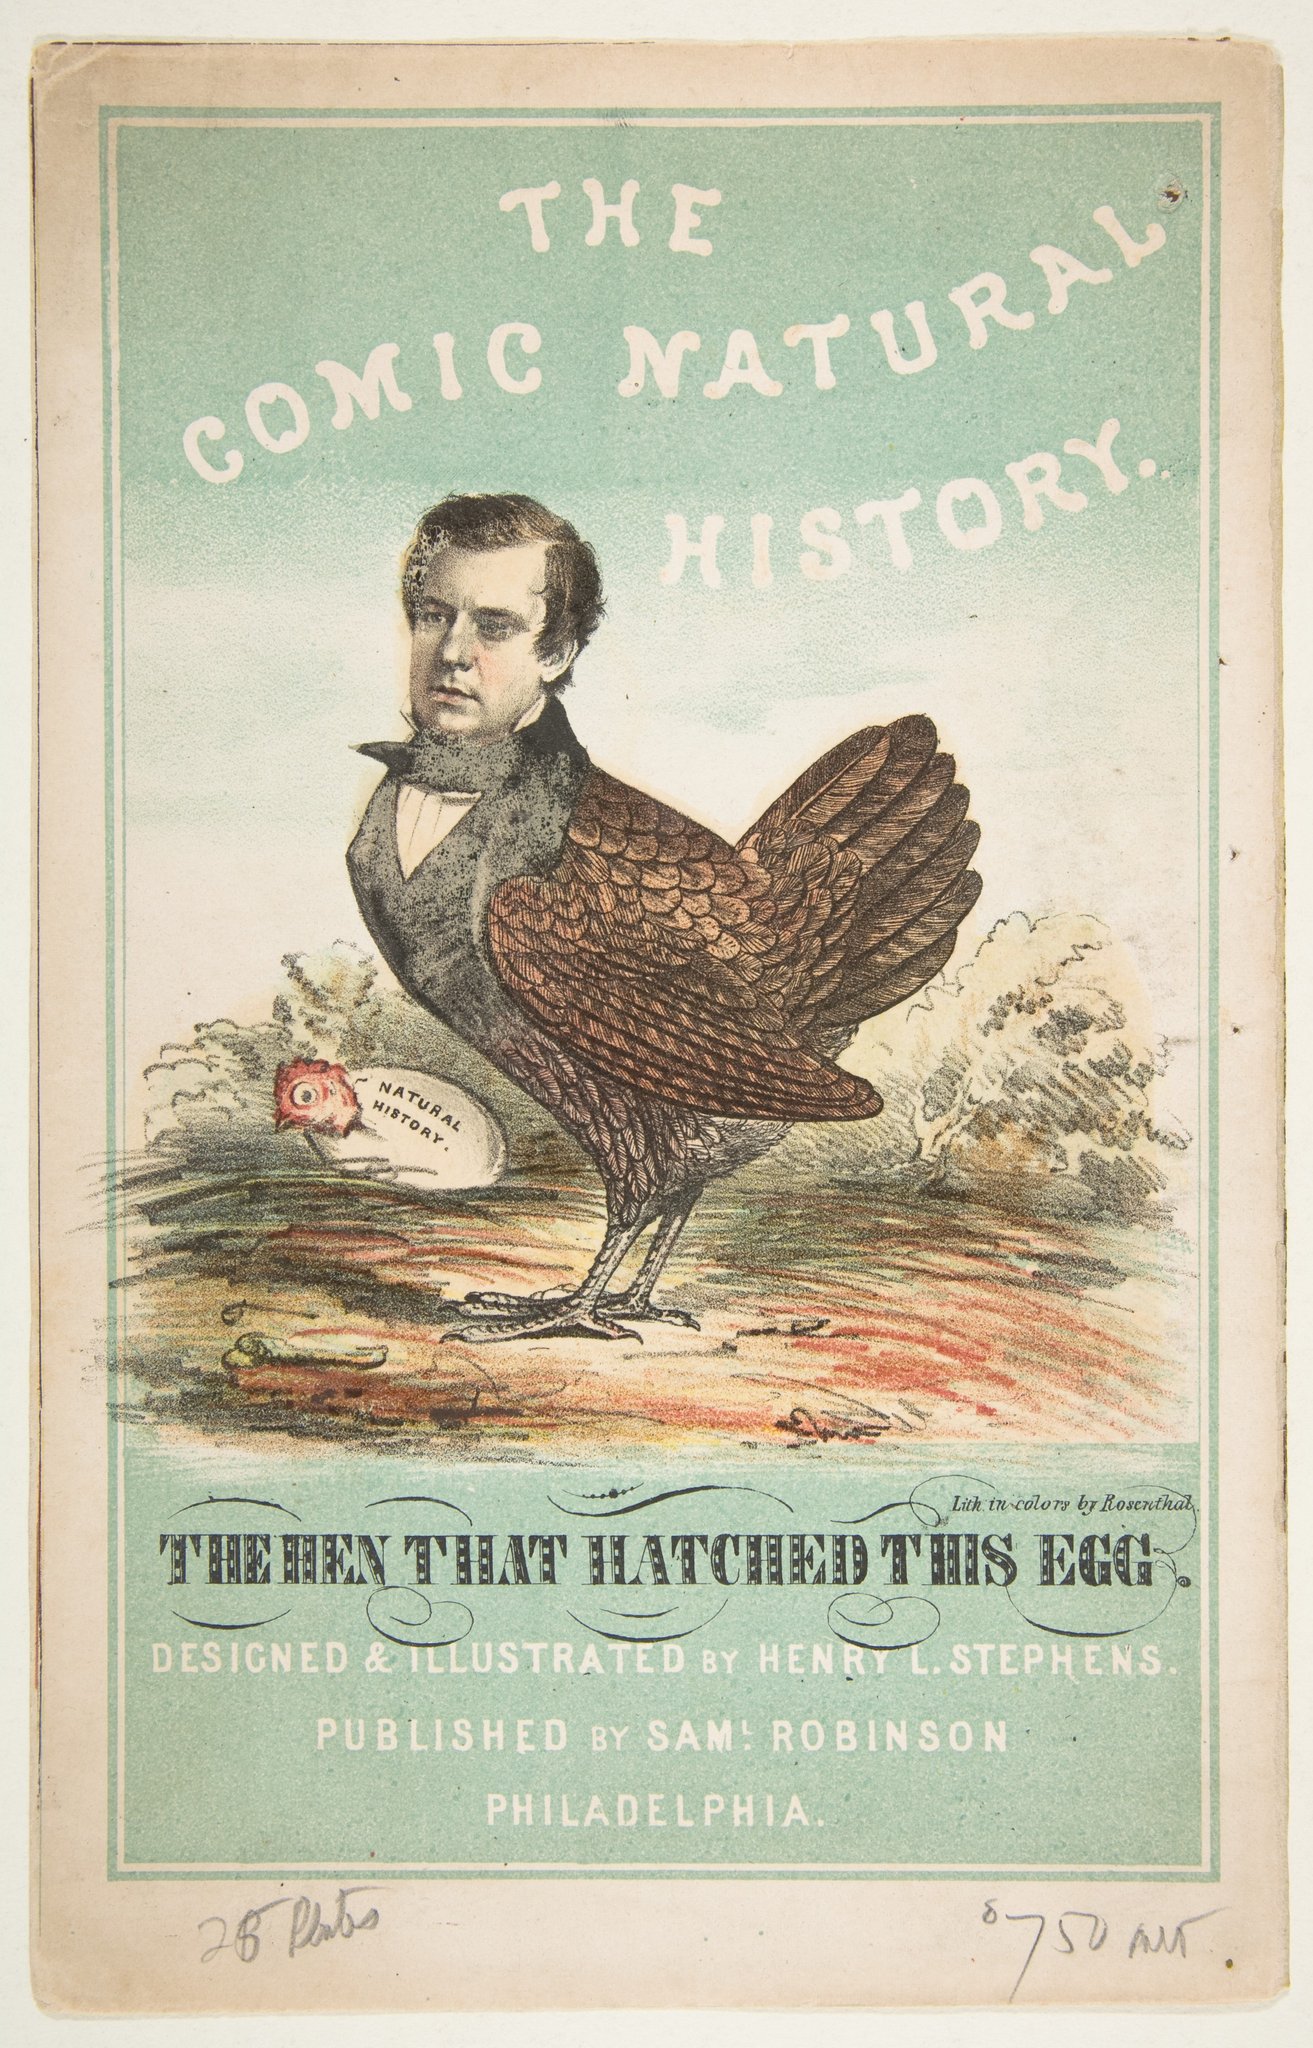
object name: print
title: The Hen That Hatched This Egg (Henry L. Stephens), Title Page, from "The Comic Natural History of the Human Race"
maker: henry louis stephens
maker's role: artist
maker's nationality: american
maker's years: 1824-1882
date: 1851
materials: watercolor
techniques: lithograph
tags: satire